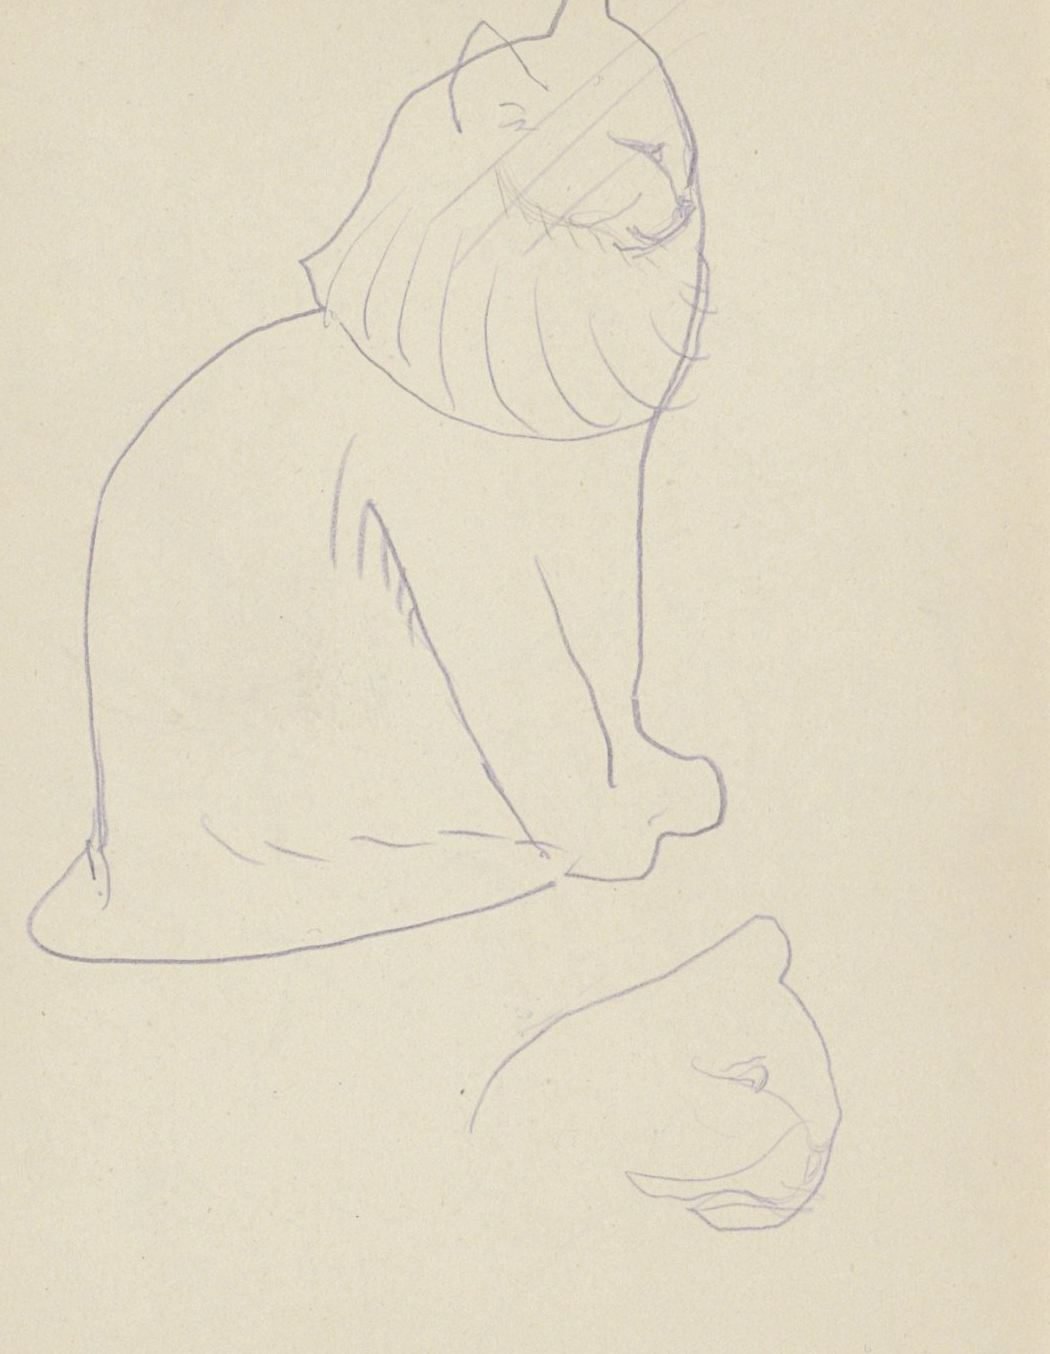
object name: sketchbook leaf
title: Zittende beer en een kop van een beer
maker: reijer stolk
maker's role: draughtsman, print maker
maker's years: 1896-1945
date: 1906-1945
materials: paper, pencil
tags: beasts of prey, predatory animals: bear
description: Blad 41 verso uit een schetsboek met 69 bladen.